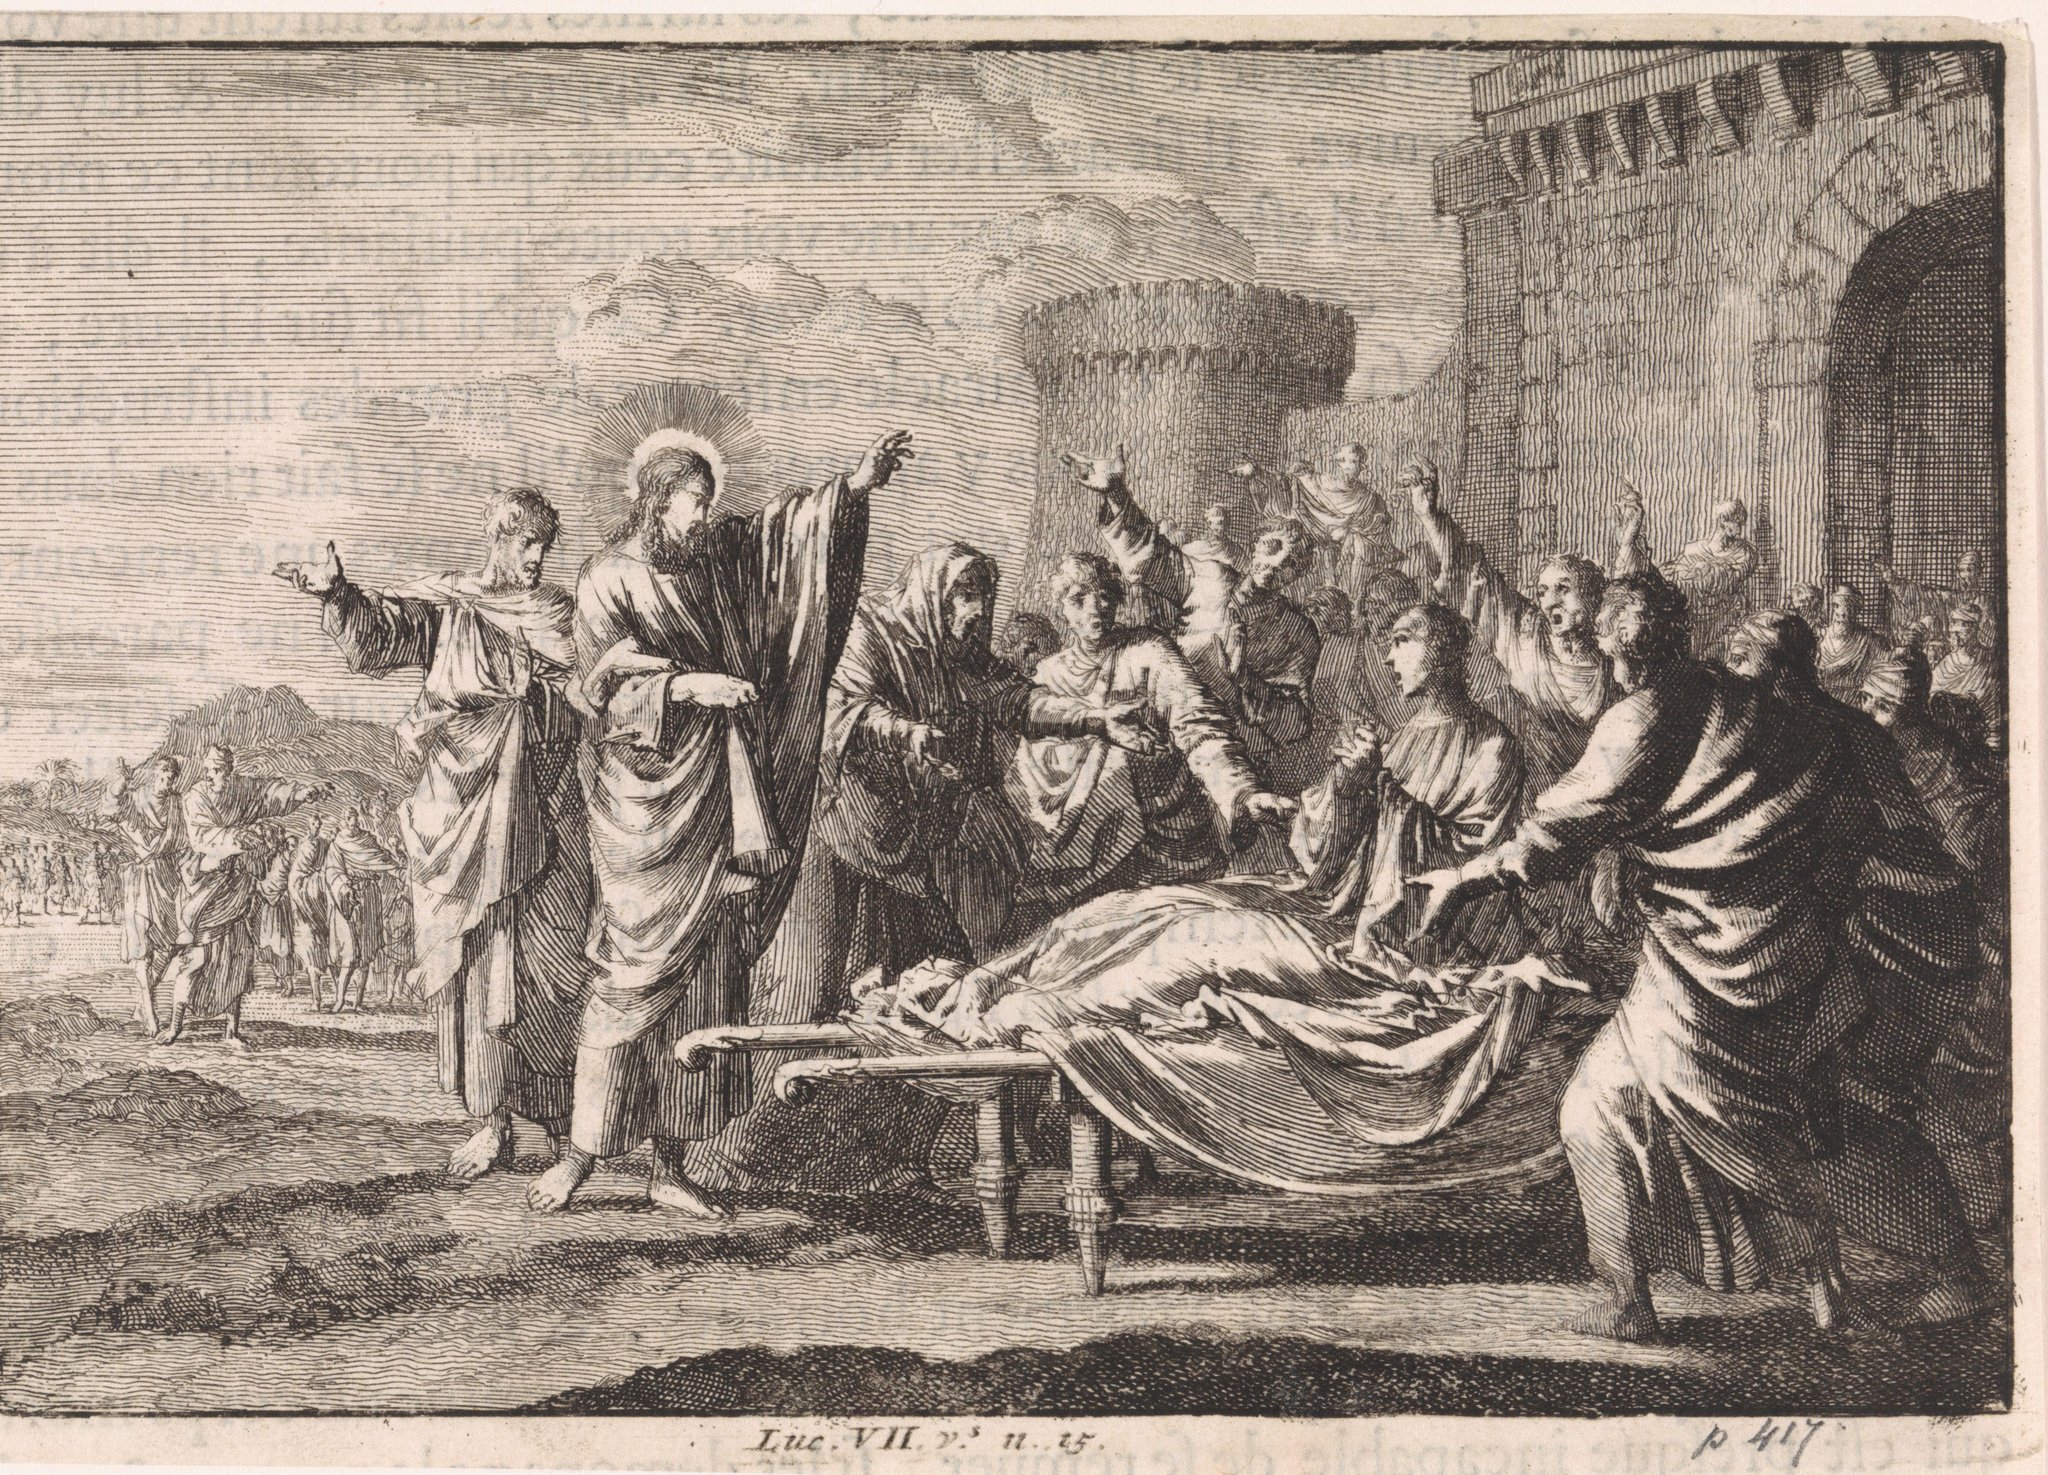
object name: book illustration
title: Opwekking van de jongeling te Naïn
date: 1703-1762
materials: paper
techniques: etching, letterpress printing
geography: amsterdam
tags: christ touches the bier of the son of the widow of nain: the young man sits up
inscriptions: collector's mark: Lugt 2228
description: De prent komt een eerste keer voor als boekillustratie voor David Martin. Historie des Ouden en Nieuwen Testaments. Amsterdam, Pieter Mortier, 1703. Deel II. De boekillustraties voor de Mortierbijbel hebben verschillende staten en kopieën, waarbij de chronologische volgorde moeilijk te achterhalen valt. Als boekillustraties werden ze bovendien herhaaldelijk opnieuw gebruikt voor andere boekwerken.